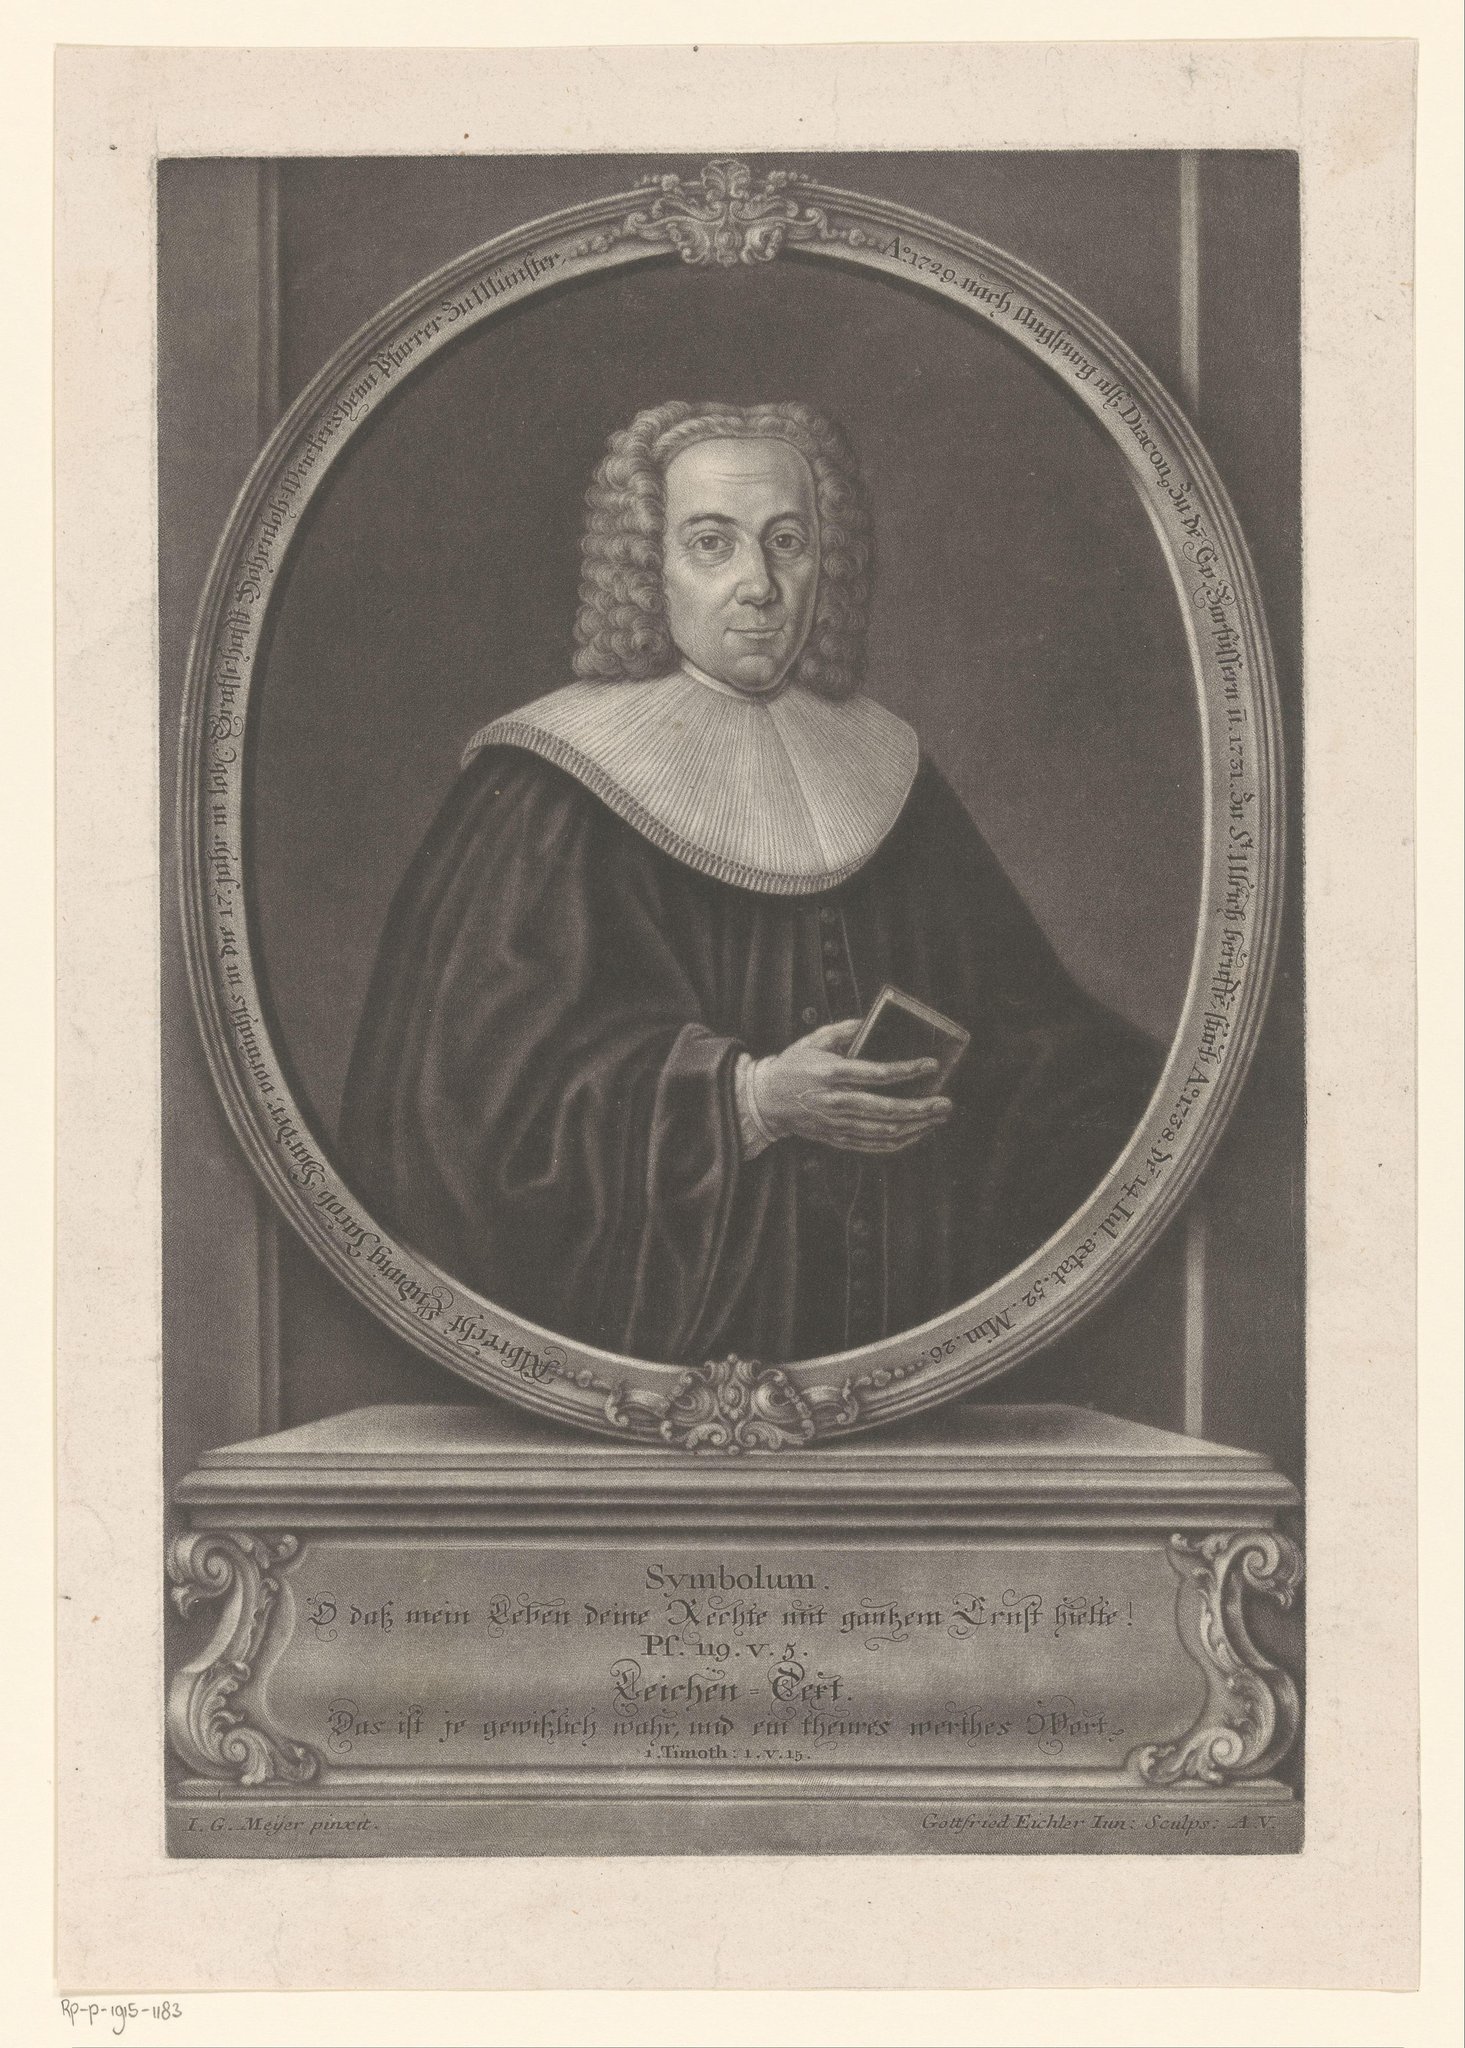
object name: print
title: Portret van Albrecht Ludwig Jakob Harder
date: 1738-1770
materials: paper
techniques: mezzotint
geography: augsburg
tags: augsburg, ornament ~ medallion, historical persons, book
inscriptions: collector's mark: Lugt 2228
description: Onderschrift met twee psalmen in het Duits.